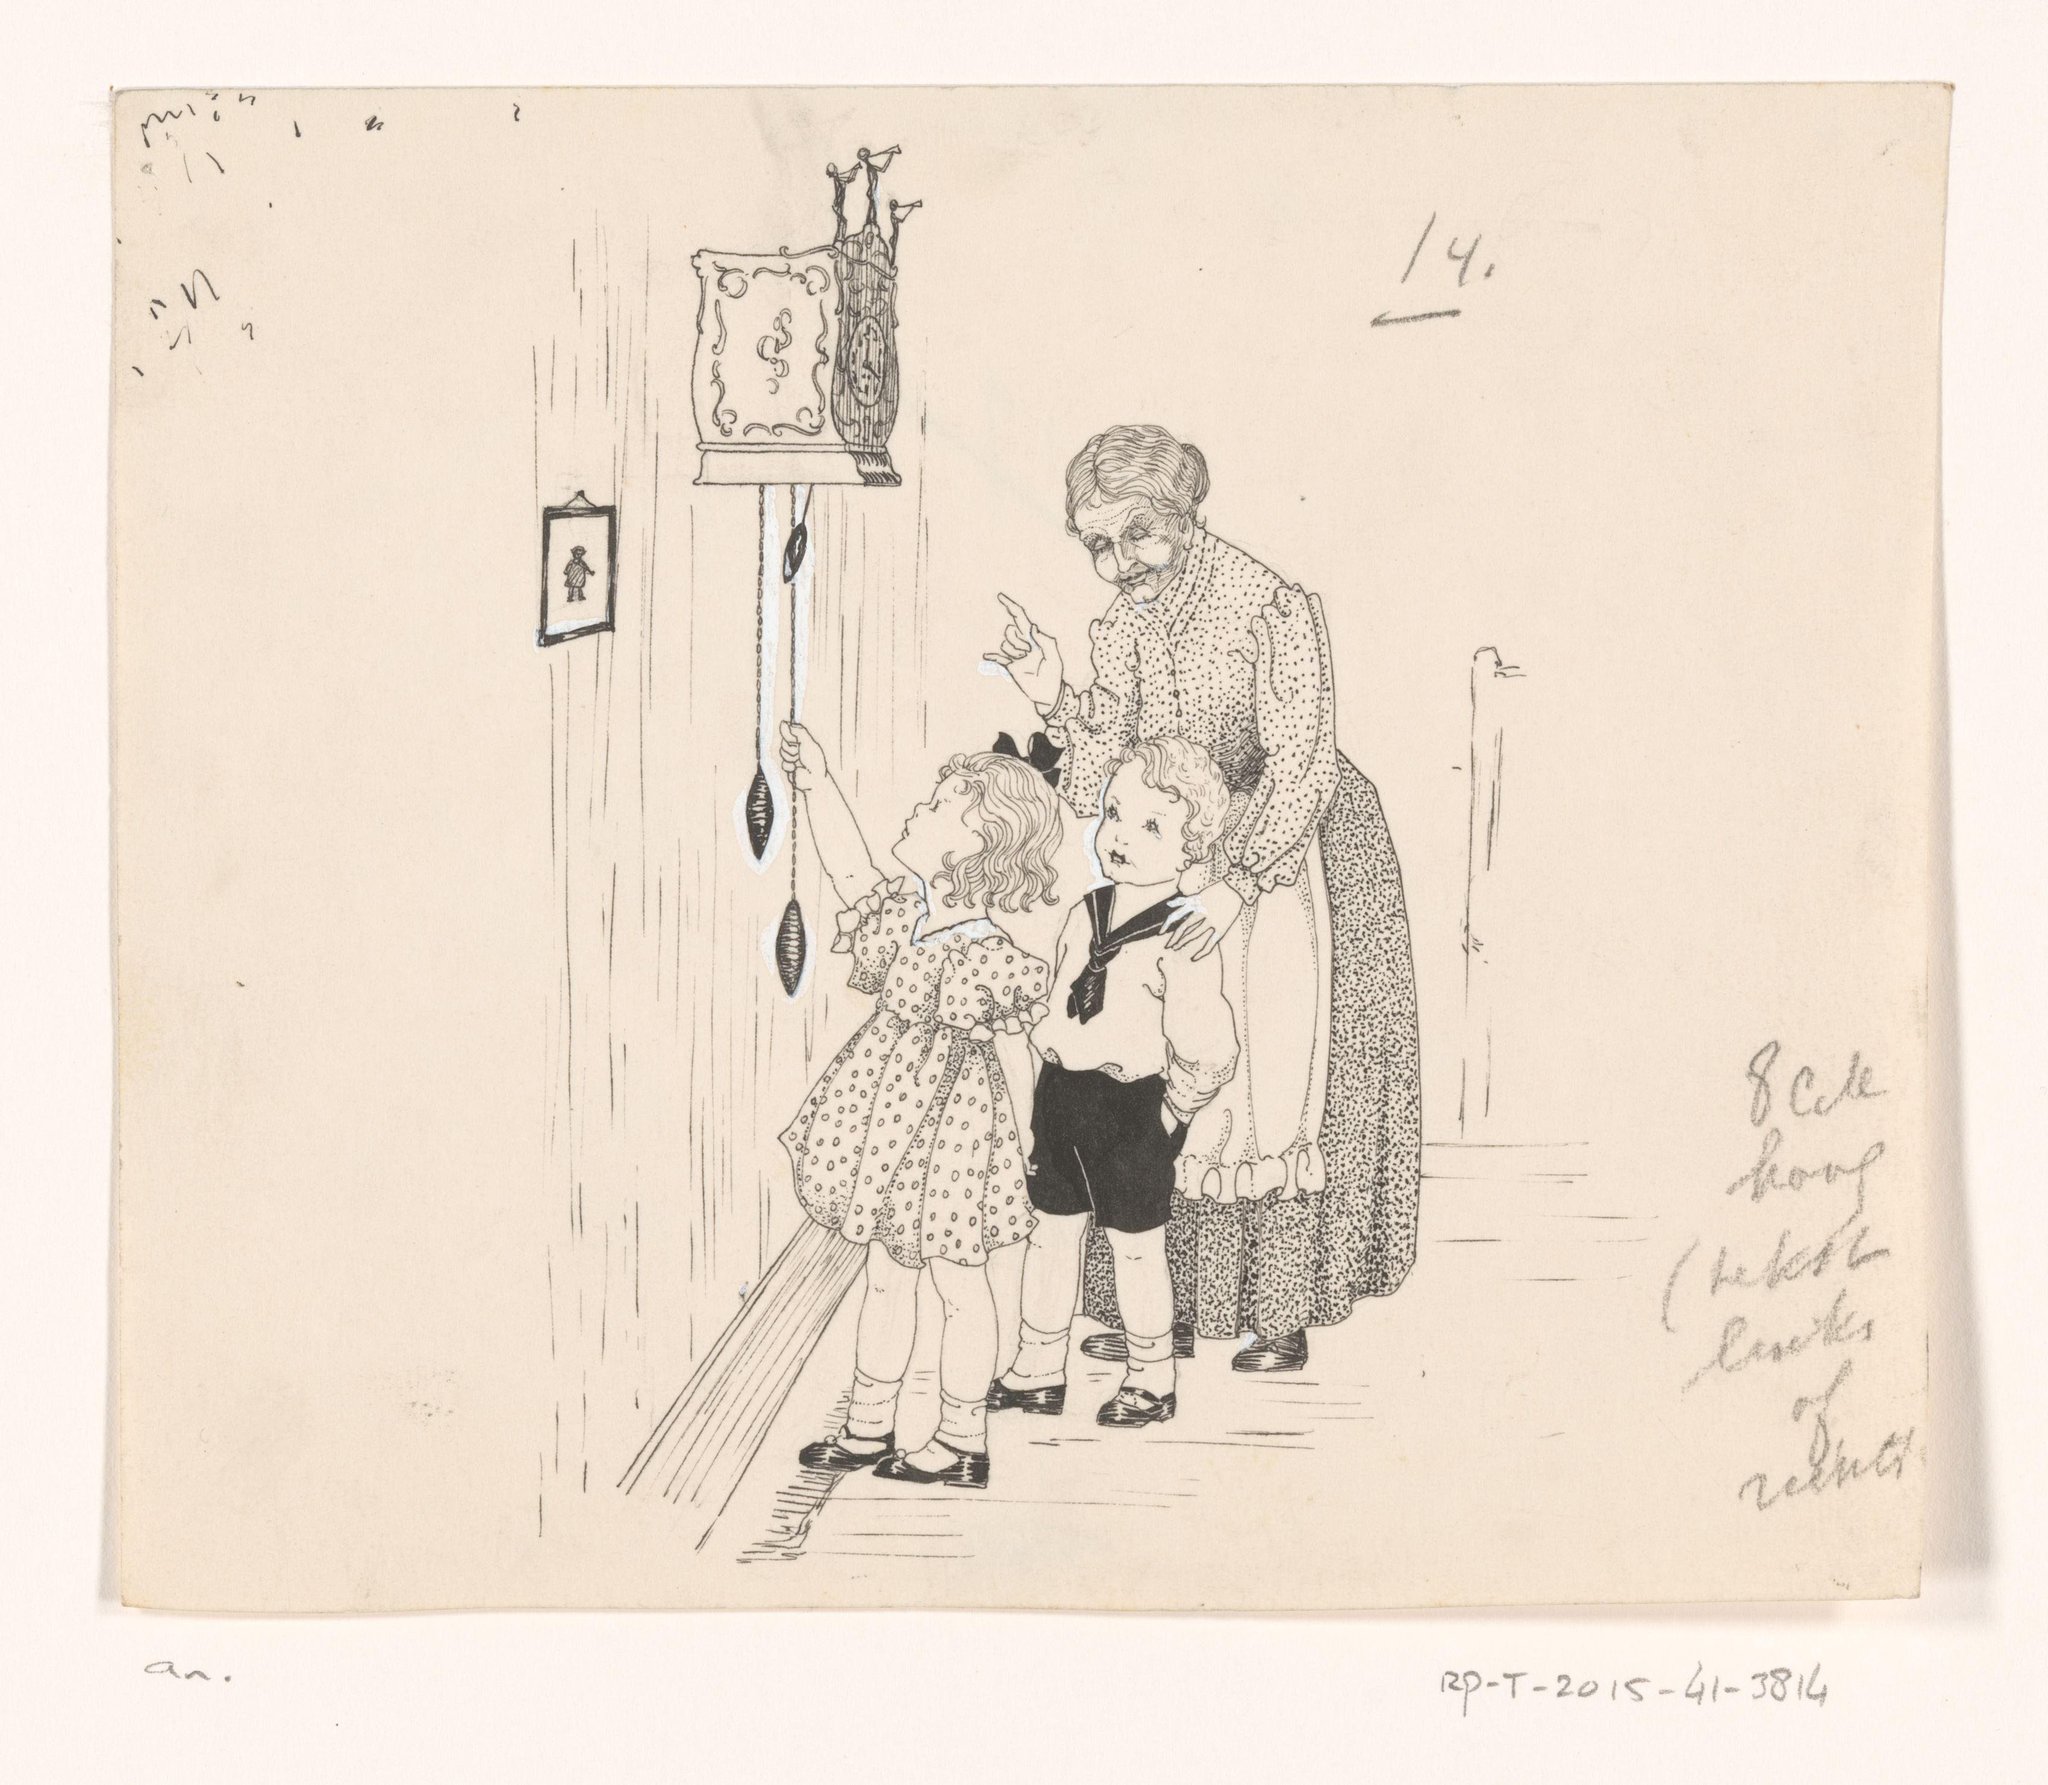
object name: boekillustratie ontwerp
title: Oude vrouw en twee kinderen bij een klok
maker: Anonymous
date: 1890-1930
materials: paint, ink, paper, pencil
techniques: brush, pen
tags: old woman, clock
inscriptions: number: ‘14.’, :, collector's mark: Lugt 2228a